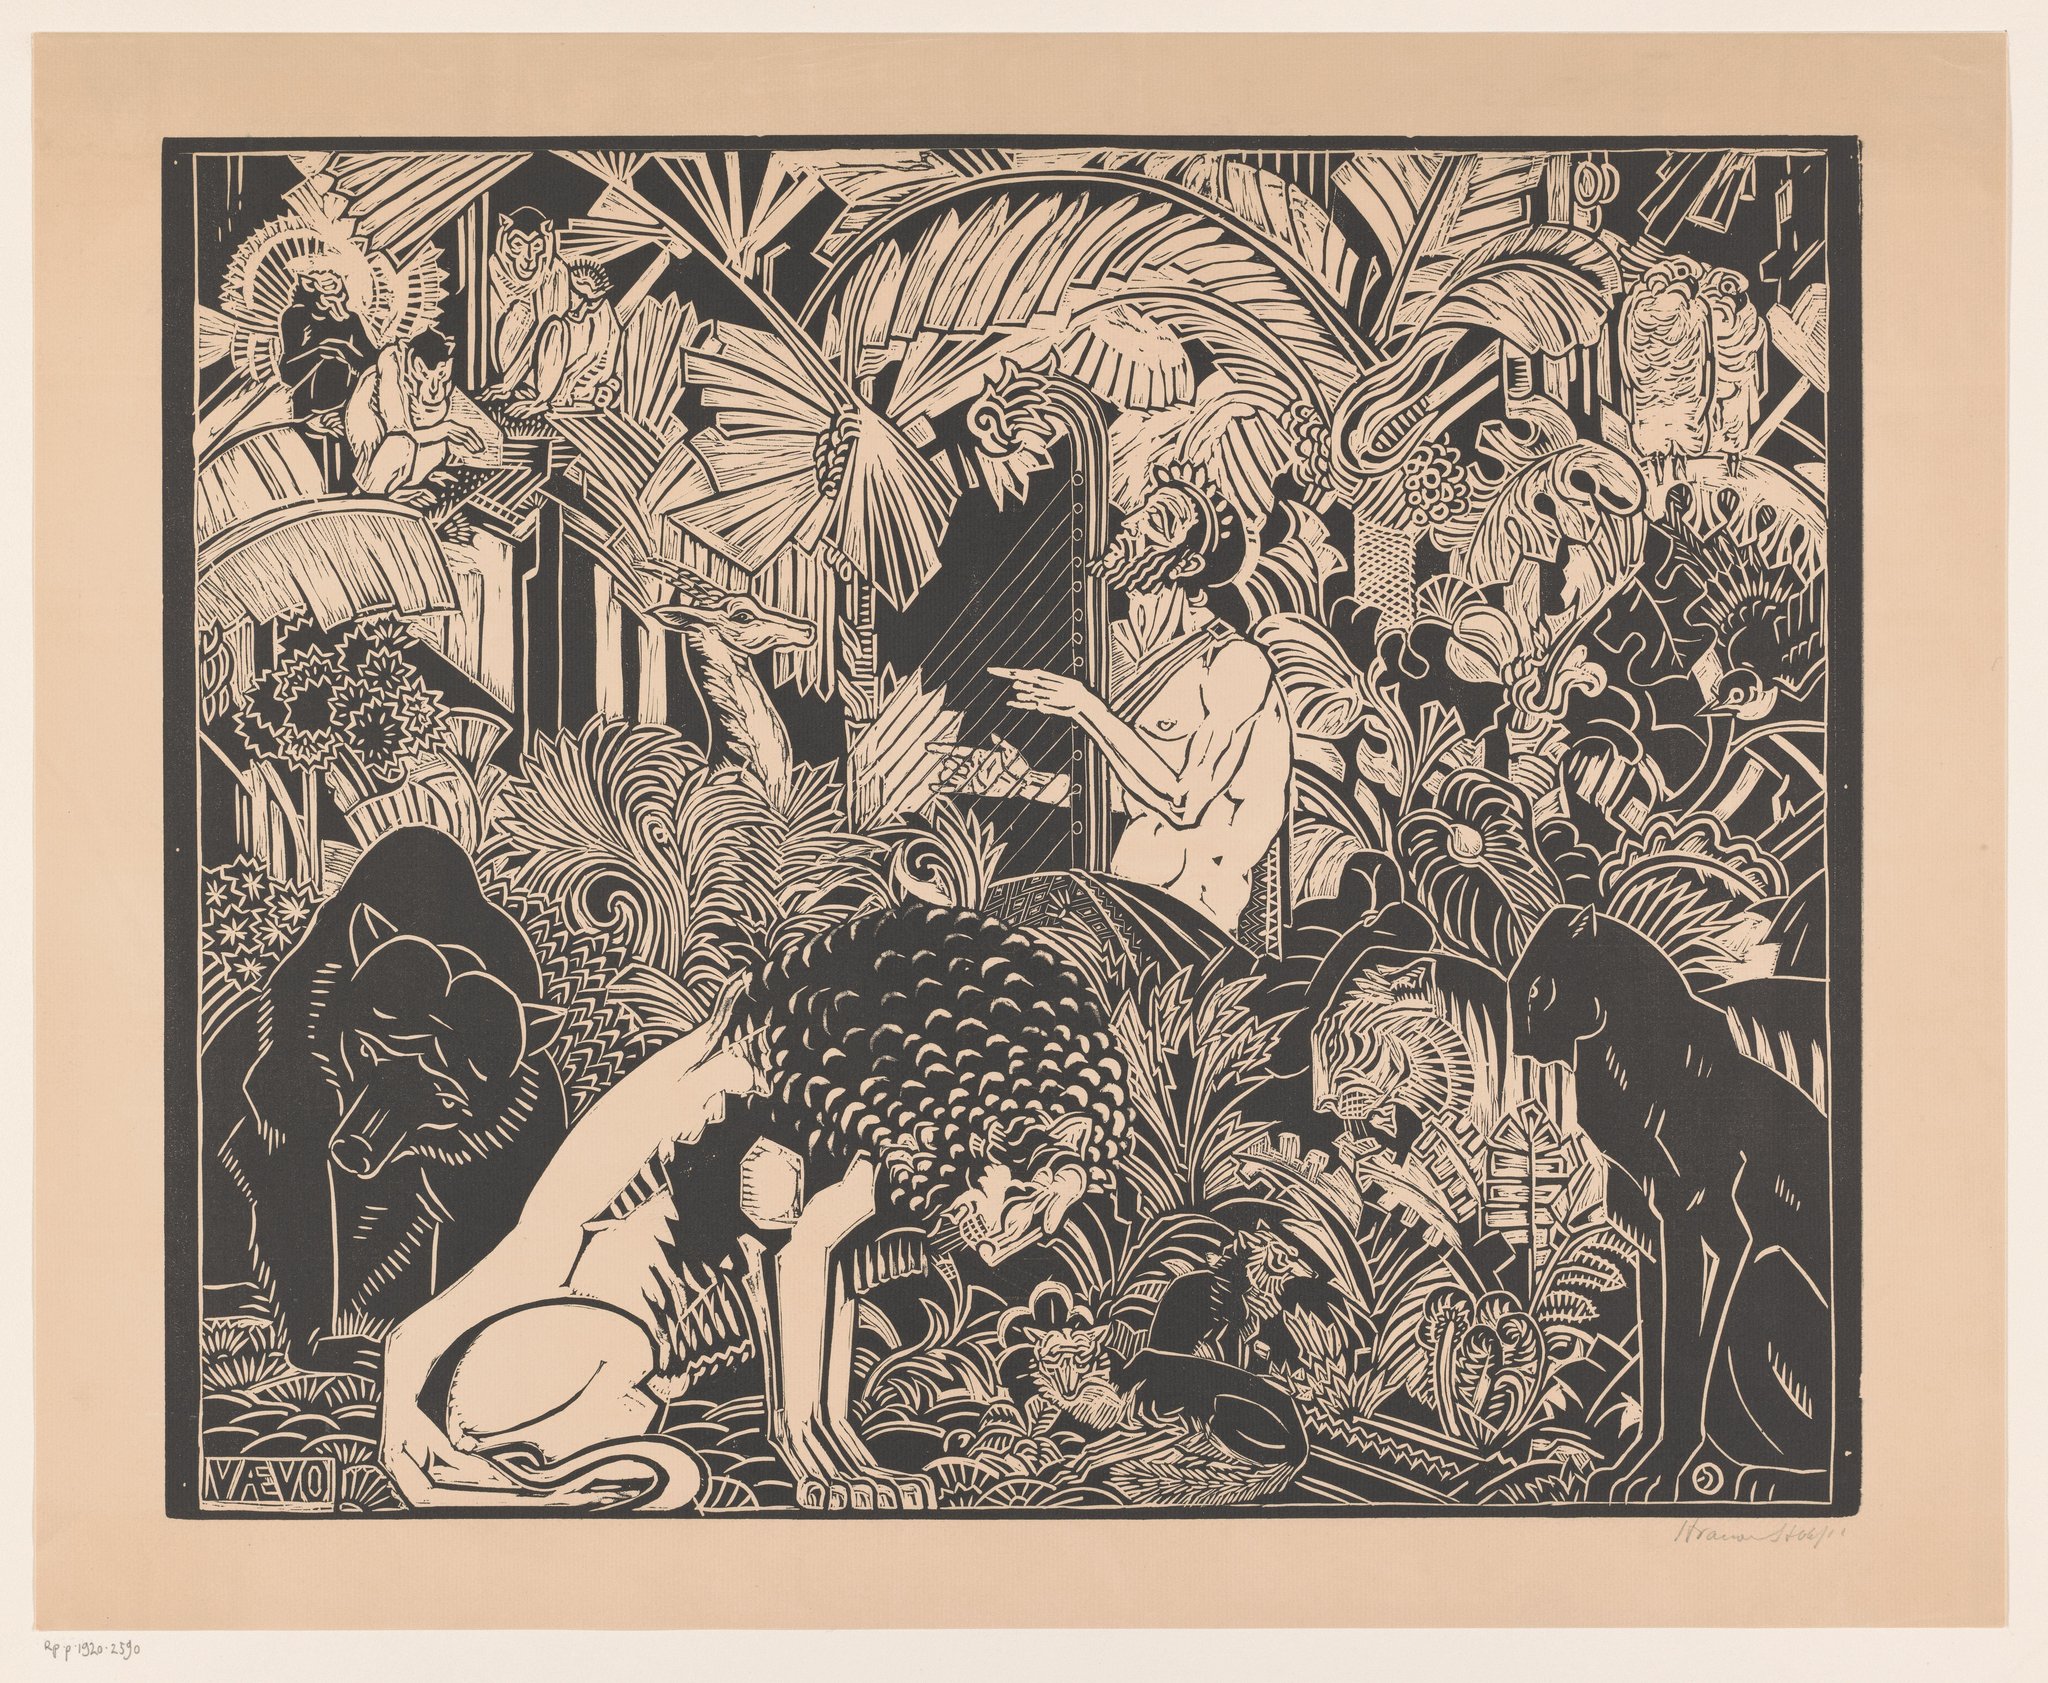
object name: print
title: Orpheus speelt op zijn harp voor de dieren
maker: henri van der stok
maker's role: print maker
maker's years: 1870-1946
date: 1917-1920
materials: paper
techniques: woodcut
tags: orpheus playing the lyre: trees and rocks move, beasts and birds are enchanted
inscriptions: collector's mark: Lugt 2233